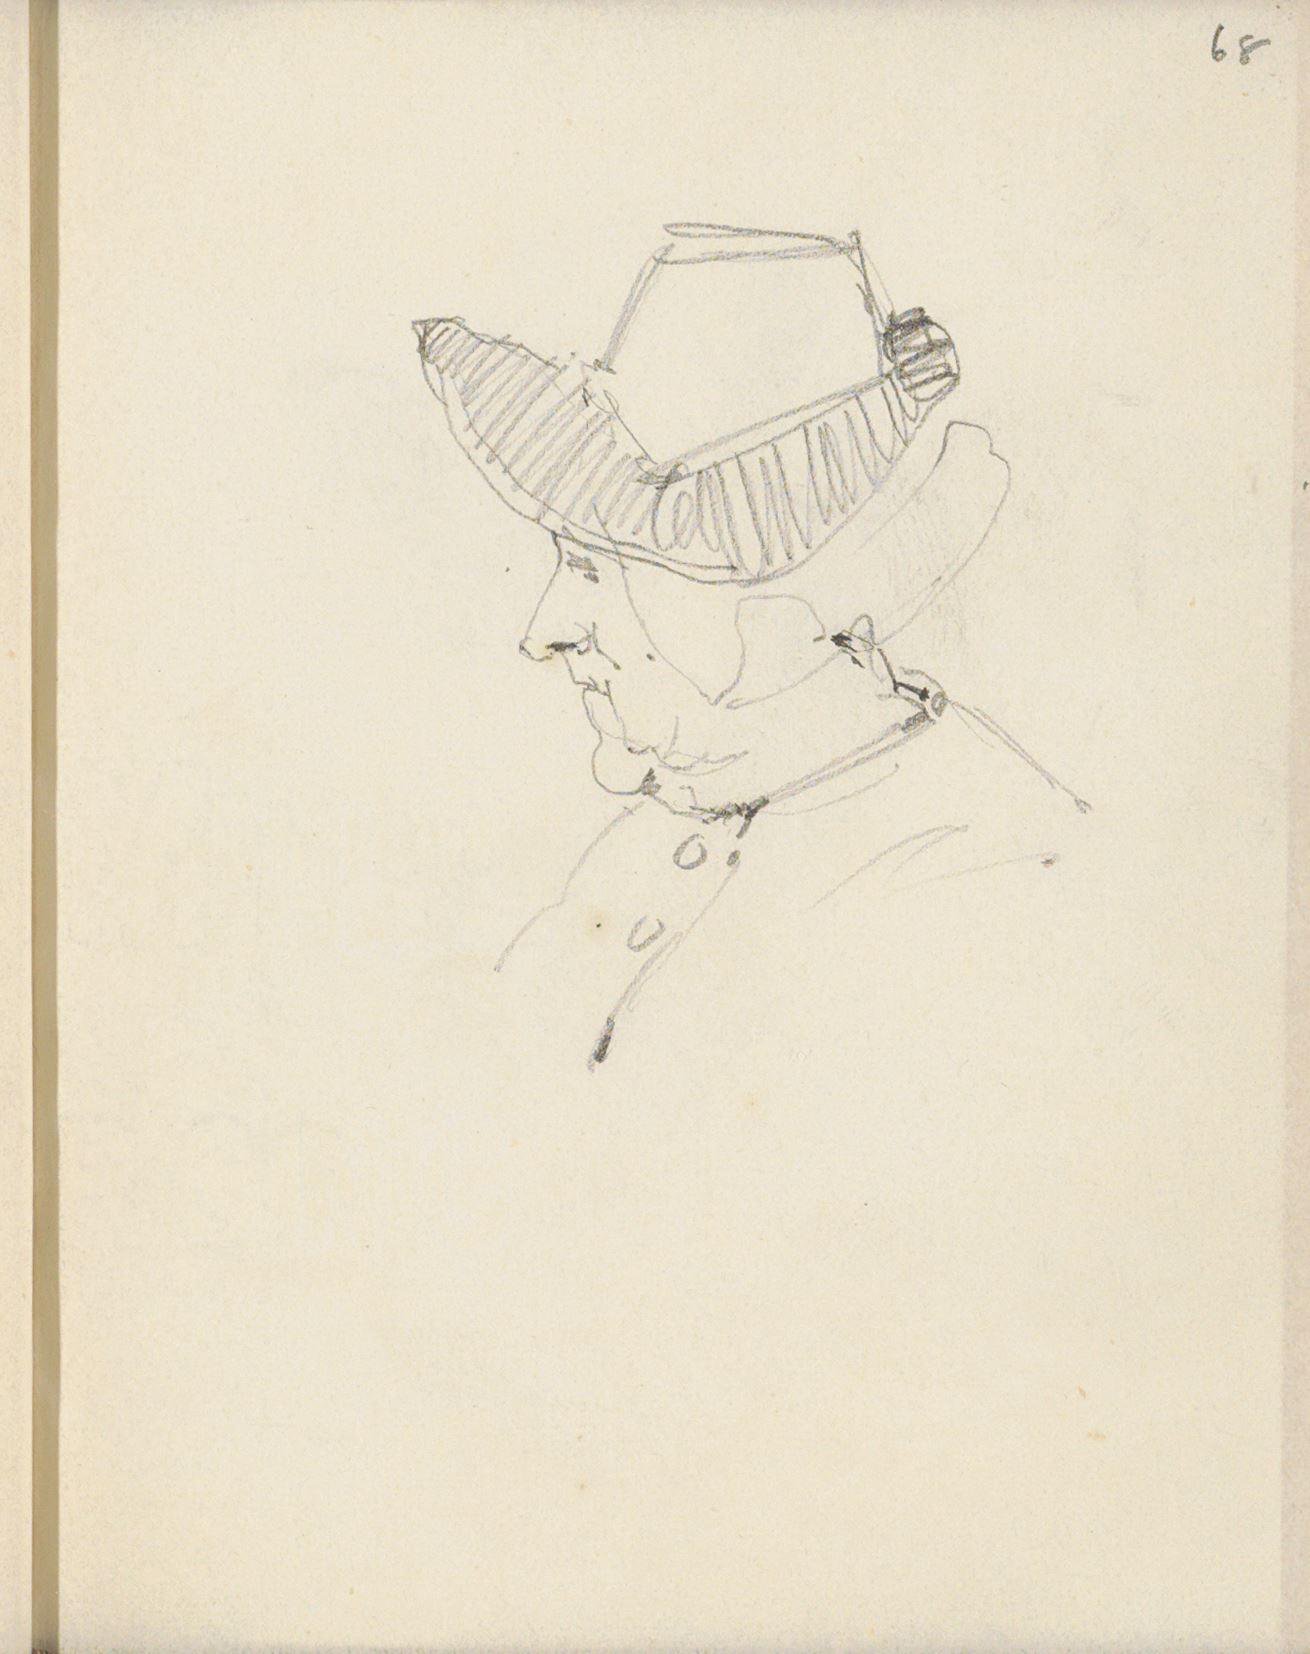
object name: sketchbook leaf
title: Hoofd van een vrouw met een kap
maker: alfred william rich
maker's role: draughtsman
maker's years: 1856-1921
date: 1892-1893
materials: paper, pencil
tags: folk costume, regional costume (+ women's clothes)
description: Blad 68 recto uit een schetsboek met 86 bladen.